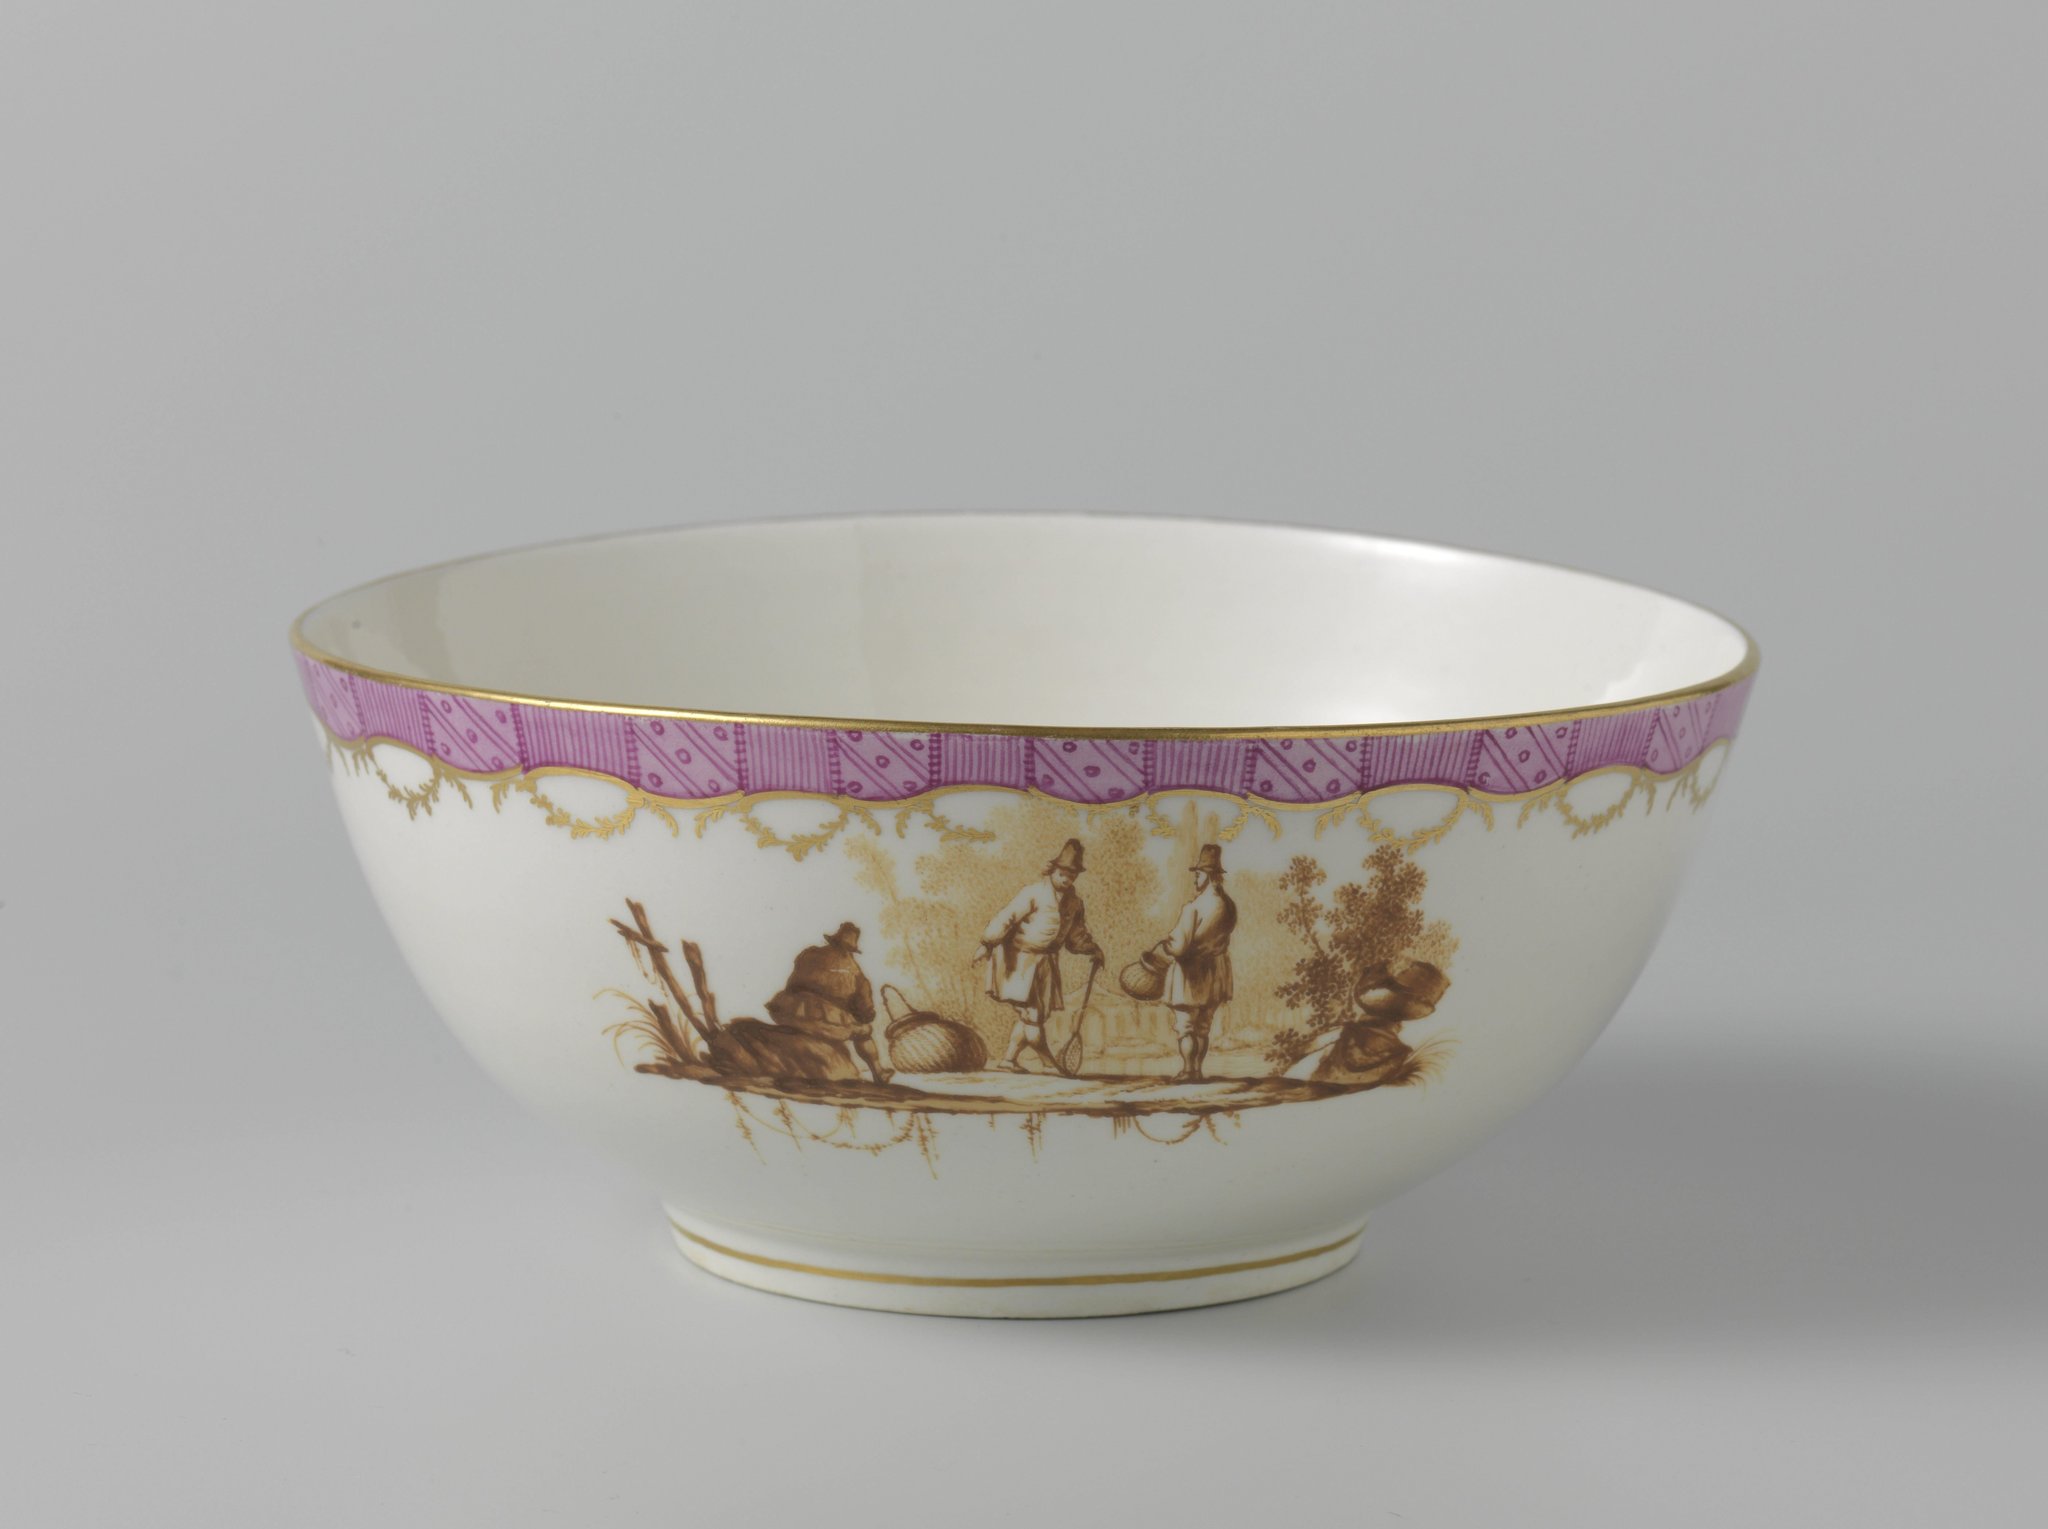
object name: slop bowl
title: Tea service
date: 1774-1778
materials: porcelain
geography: loosdrecht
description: Tea services represented a significant part of the production of the Loosdrecht porcelain factory. On display here are a teapot, milk jug and sugar bowl along with other less familiar parts of a tea service, such as a slop bowl, which is used to rinse and warm the cups between two ‘courses’, and a drip catcher (pattipan), which catches the drips from the spout of the teapot.